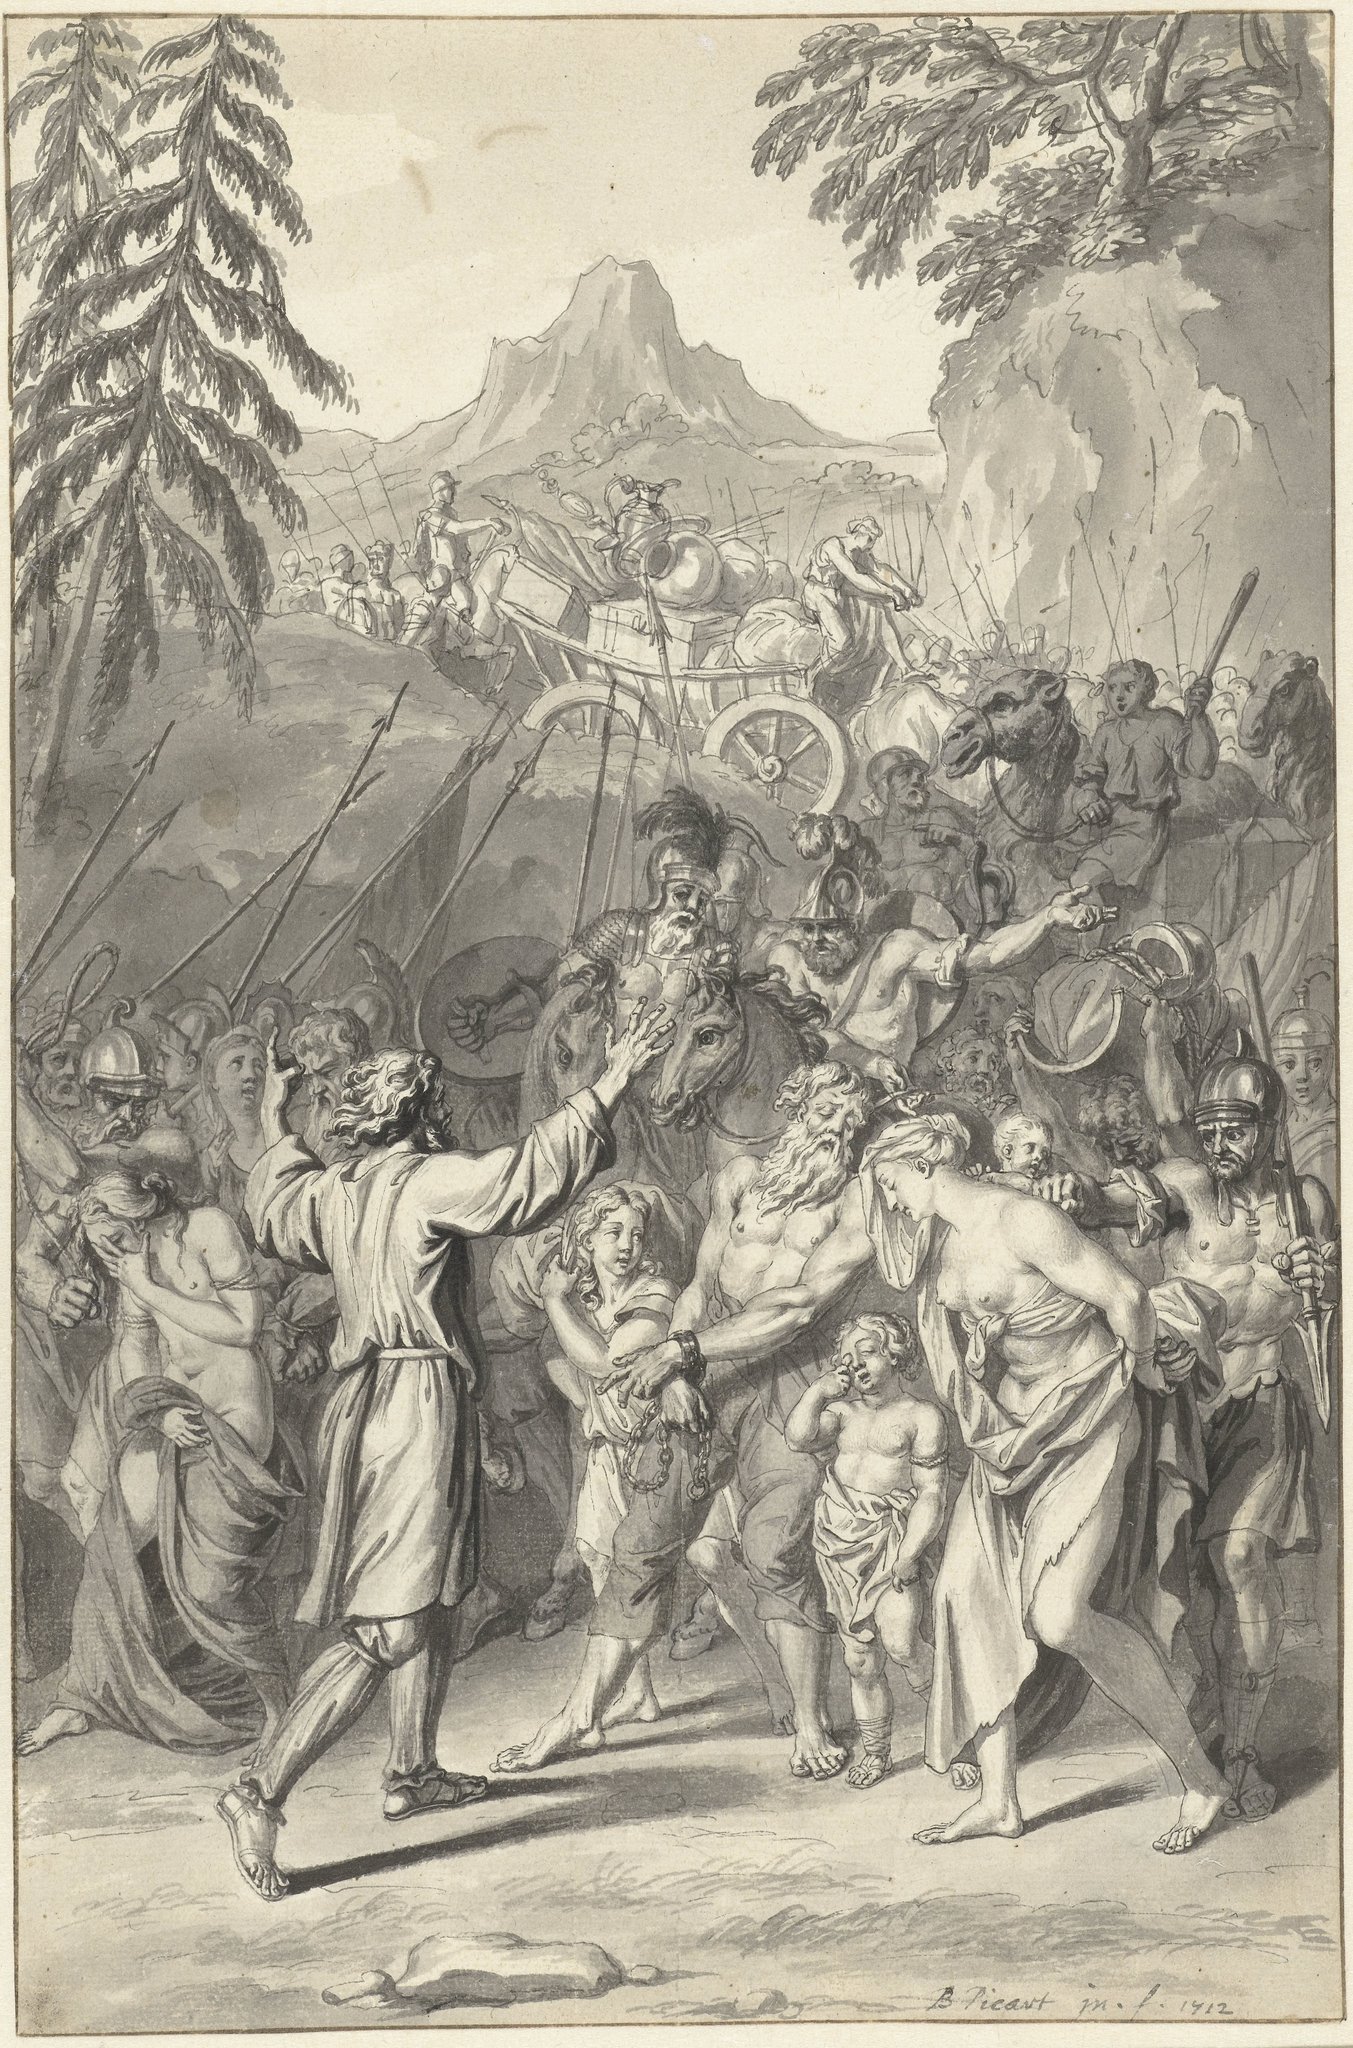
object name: drawing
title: Oded bij het leger der Israëlieten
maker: bernard picart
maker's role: draughtsman, print maker, publisher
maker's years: 1673-1733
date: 1712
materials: ink, paper, pencil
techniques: brush, pen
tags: oded, a prophet, meets the returning israelite army with the judaean prisoners and exhorts the israelites to let the prisoners go